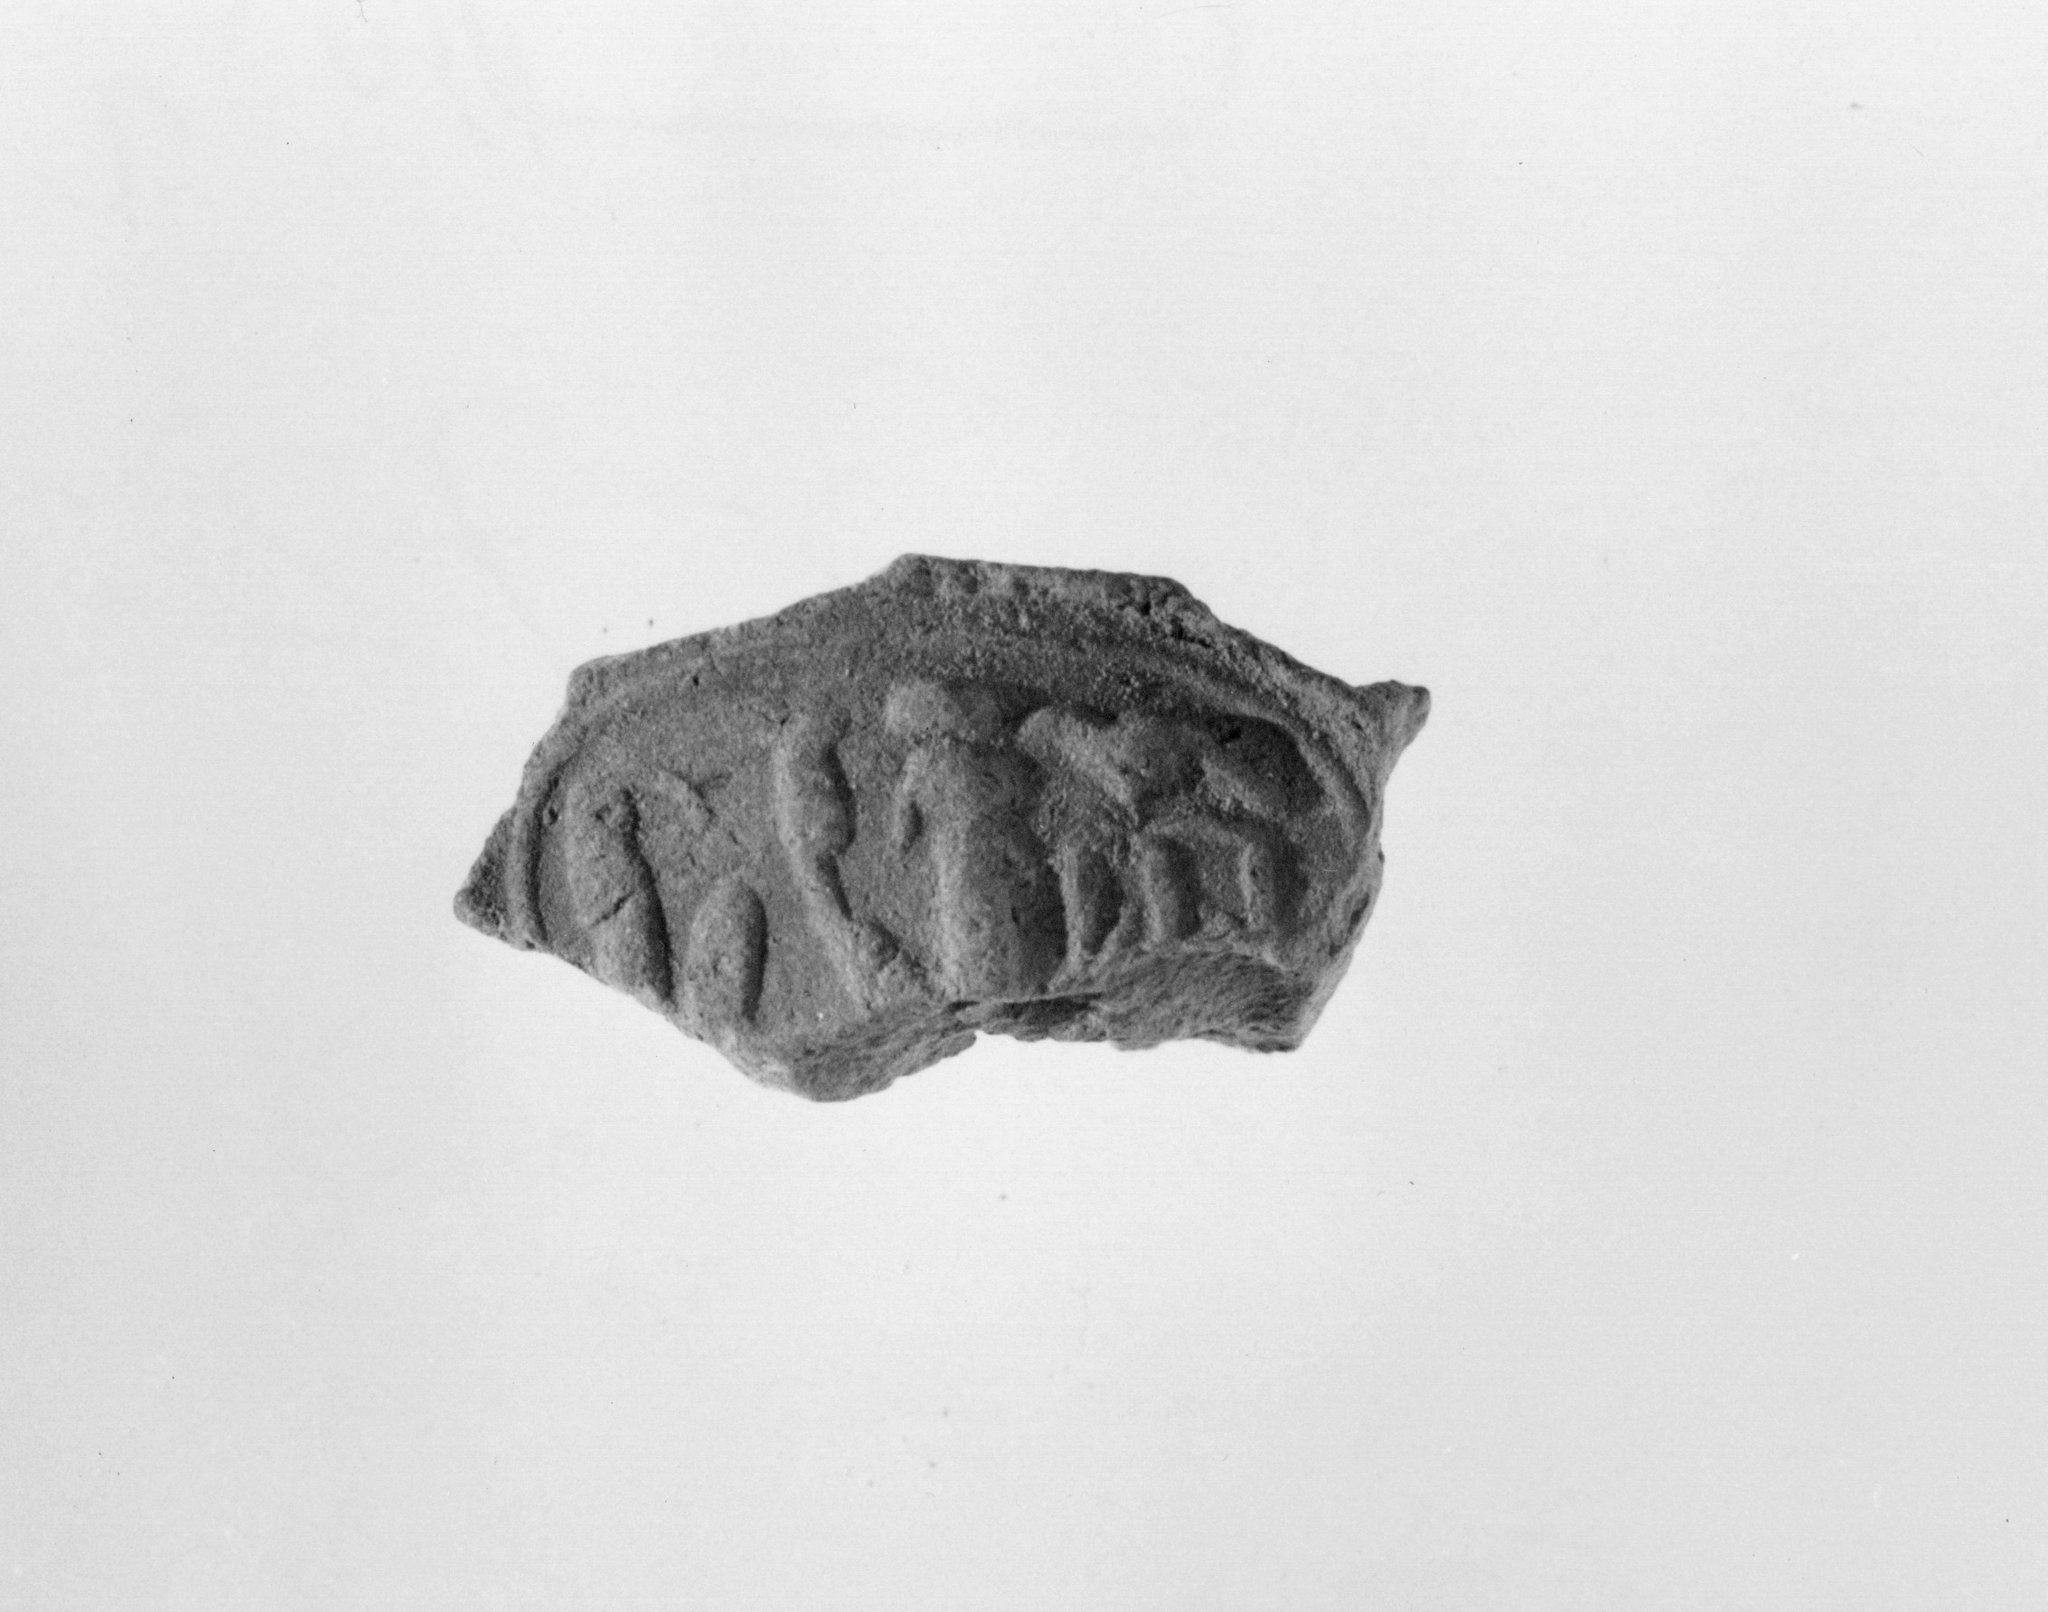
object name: sealing, nebmaatre, amenhotep iii, heb sed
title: Document Sealing With the Throne Name of Amenhotep III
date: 1390-1352 BCE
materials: mud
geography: egypt